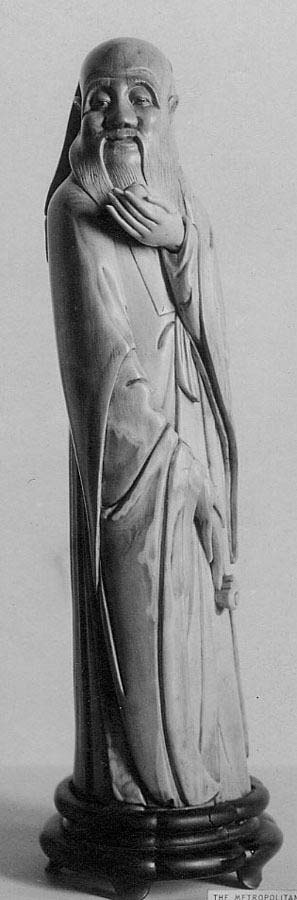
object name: figure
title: Carved Figure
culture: chinese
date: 1662-1722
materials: ivory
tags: men